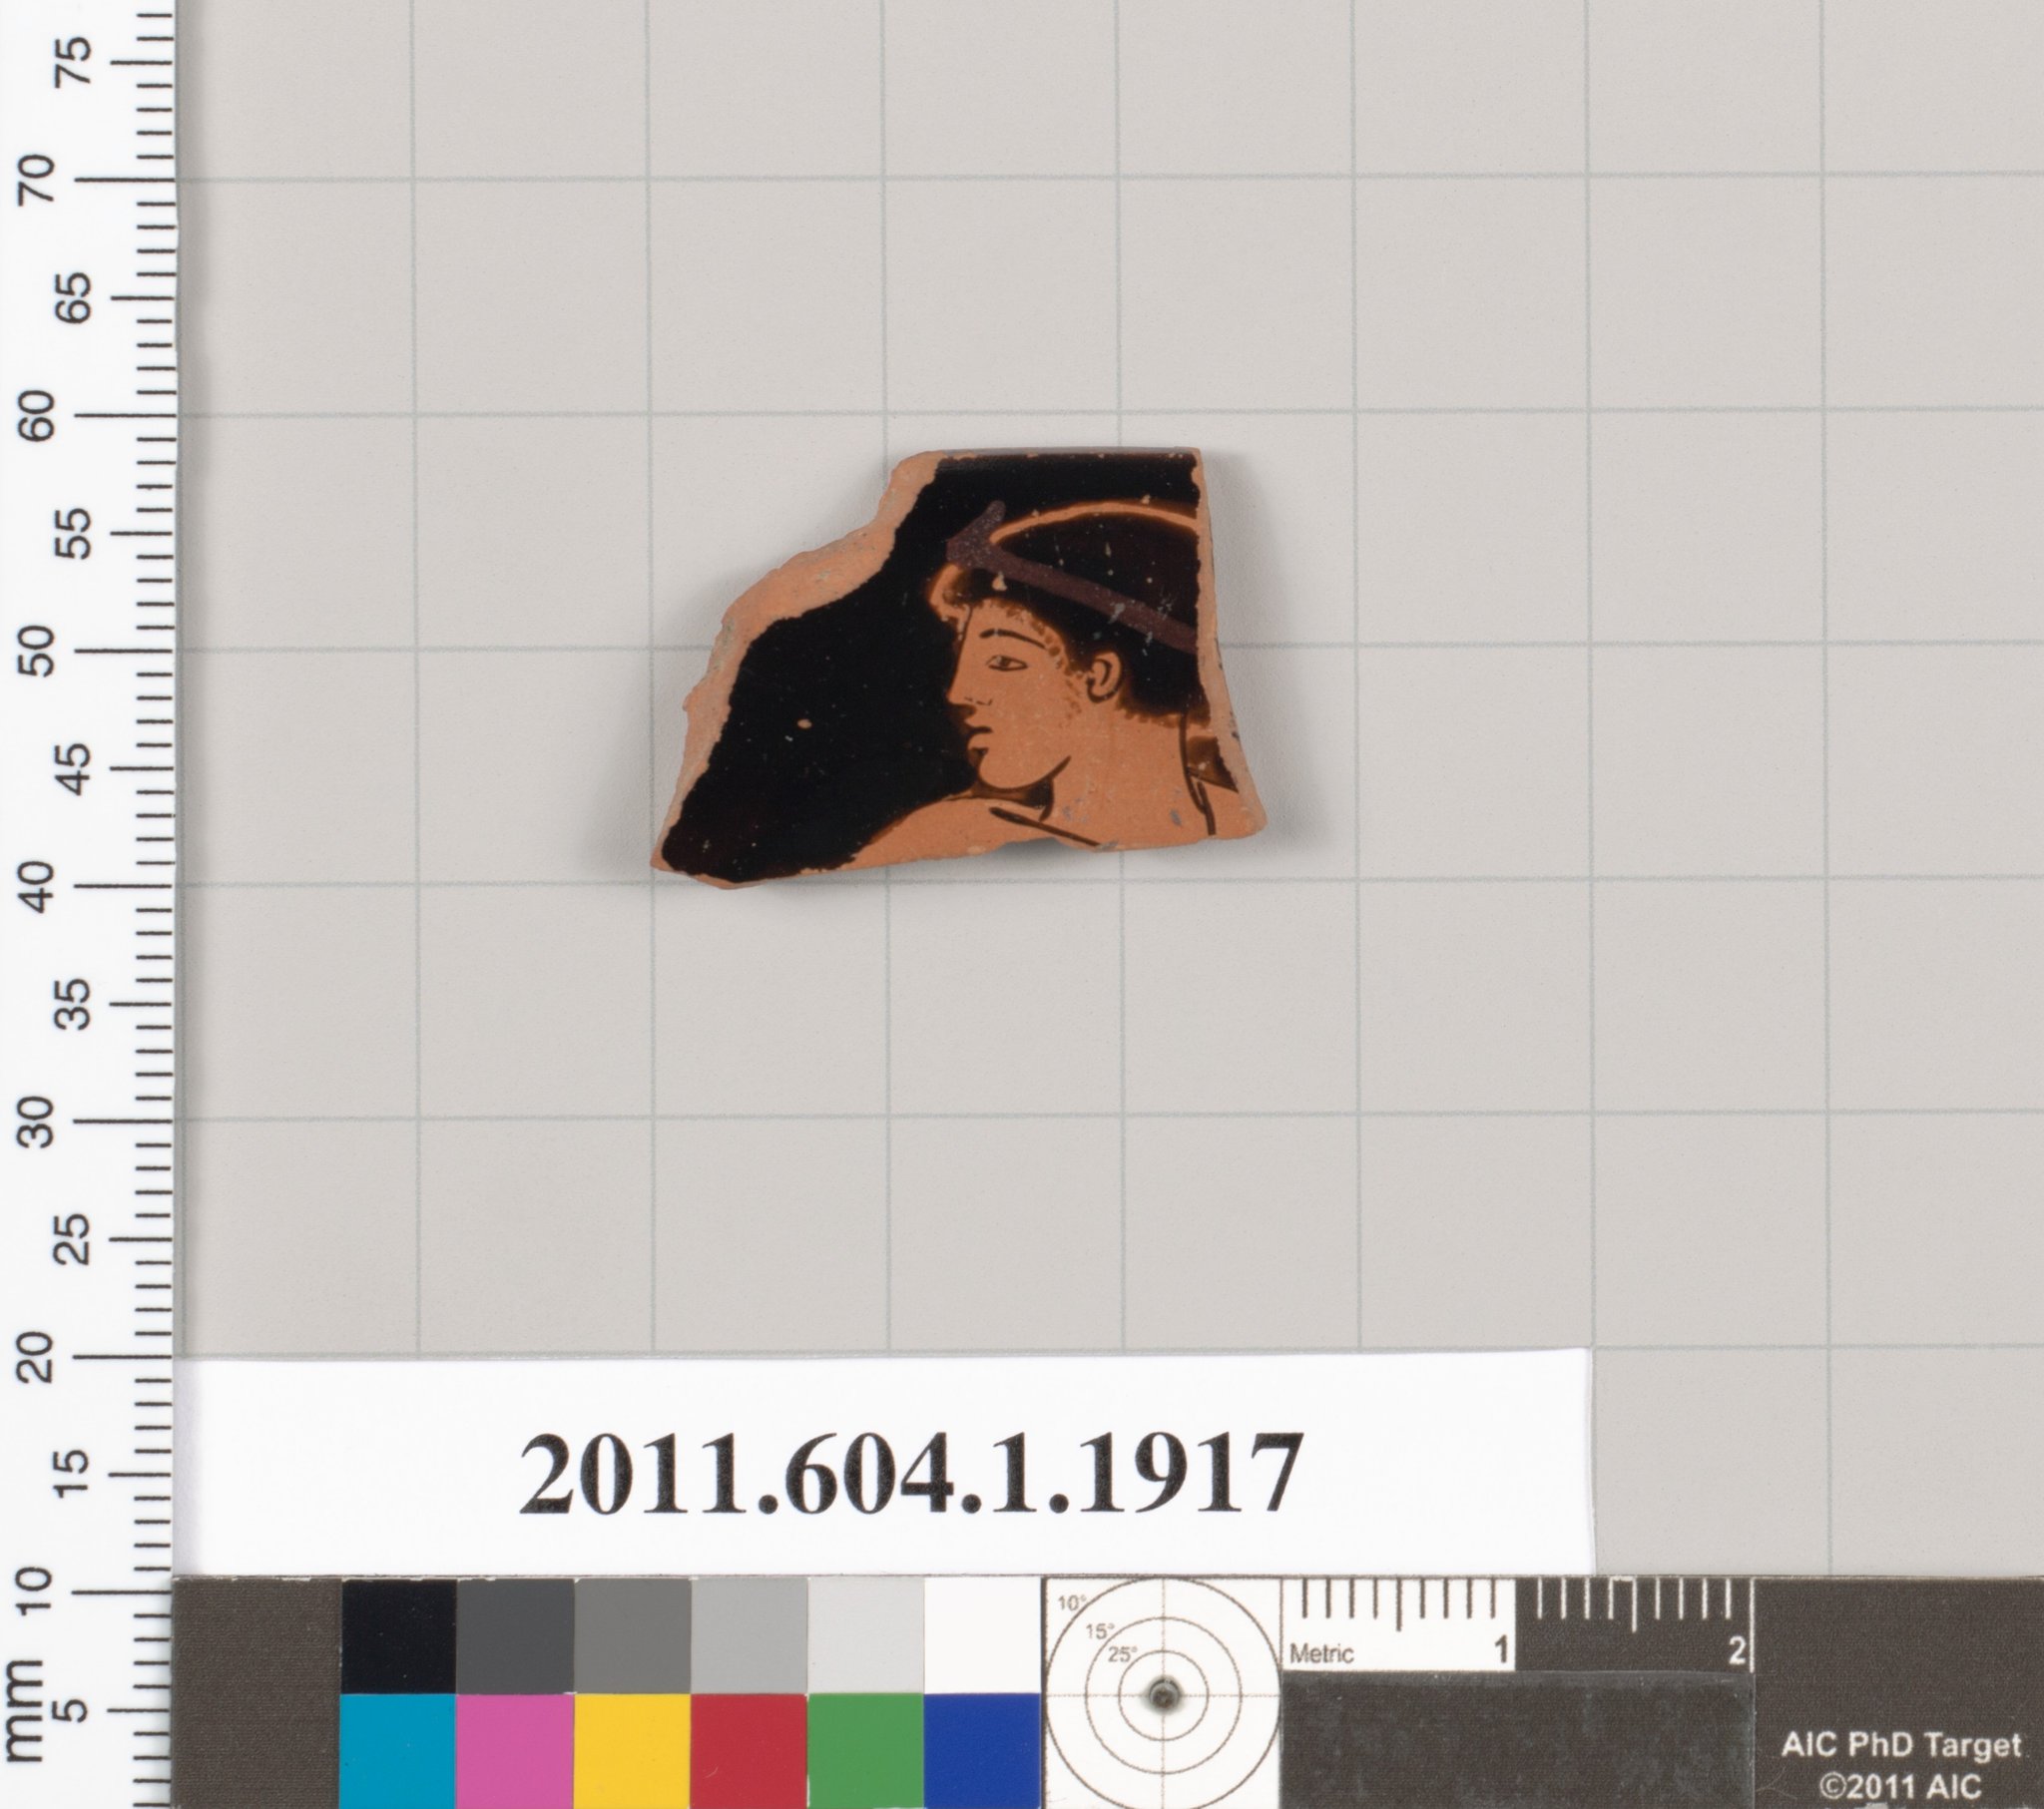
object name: kylix fragment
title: Terracotta rim fragment of a kylix (drinking cup)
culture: greek, attic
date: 475-451 BCE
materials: terracotta